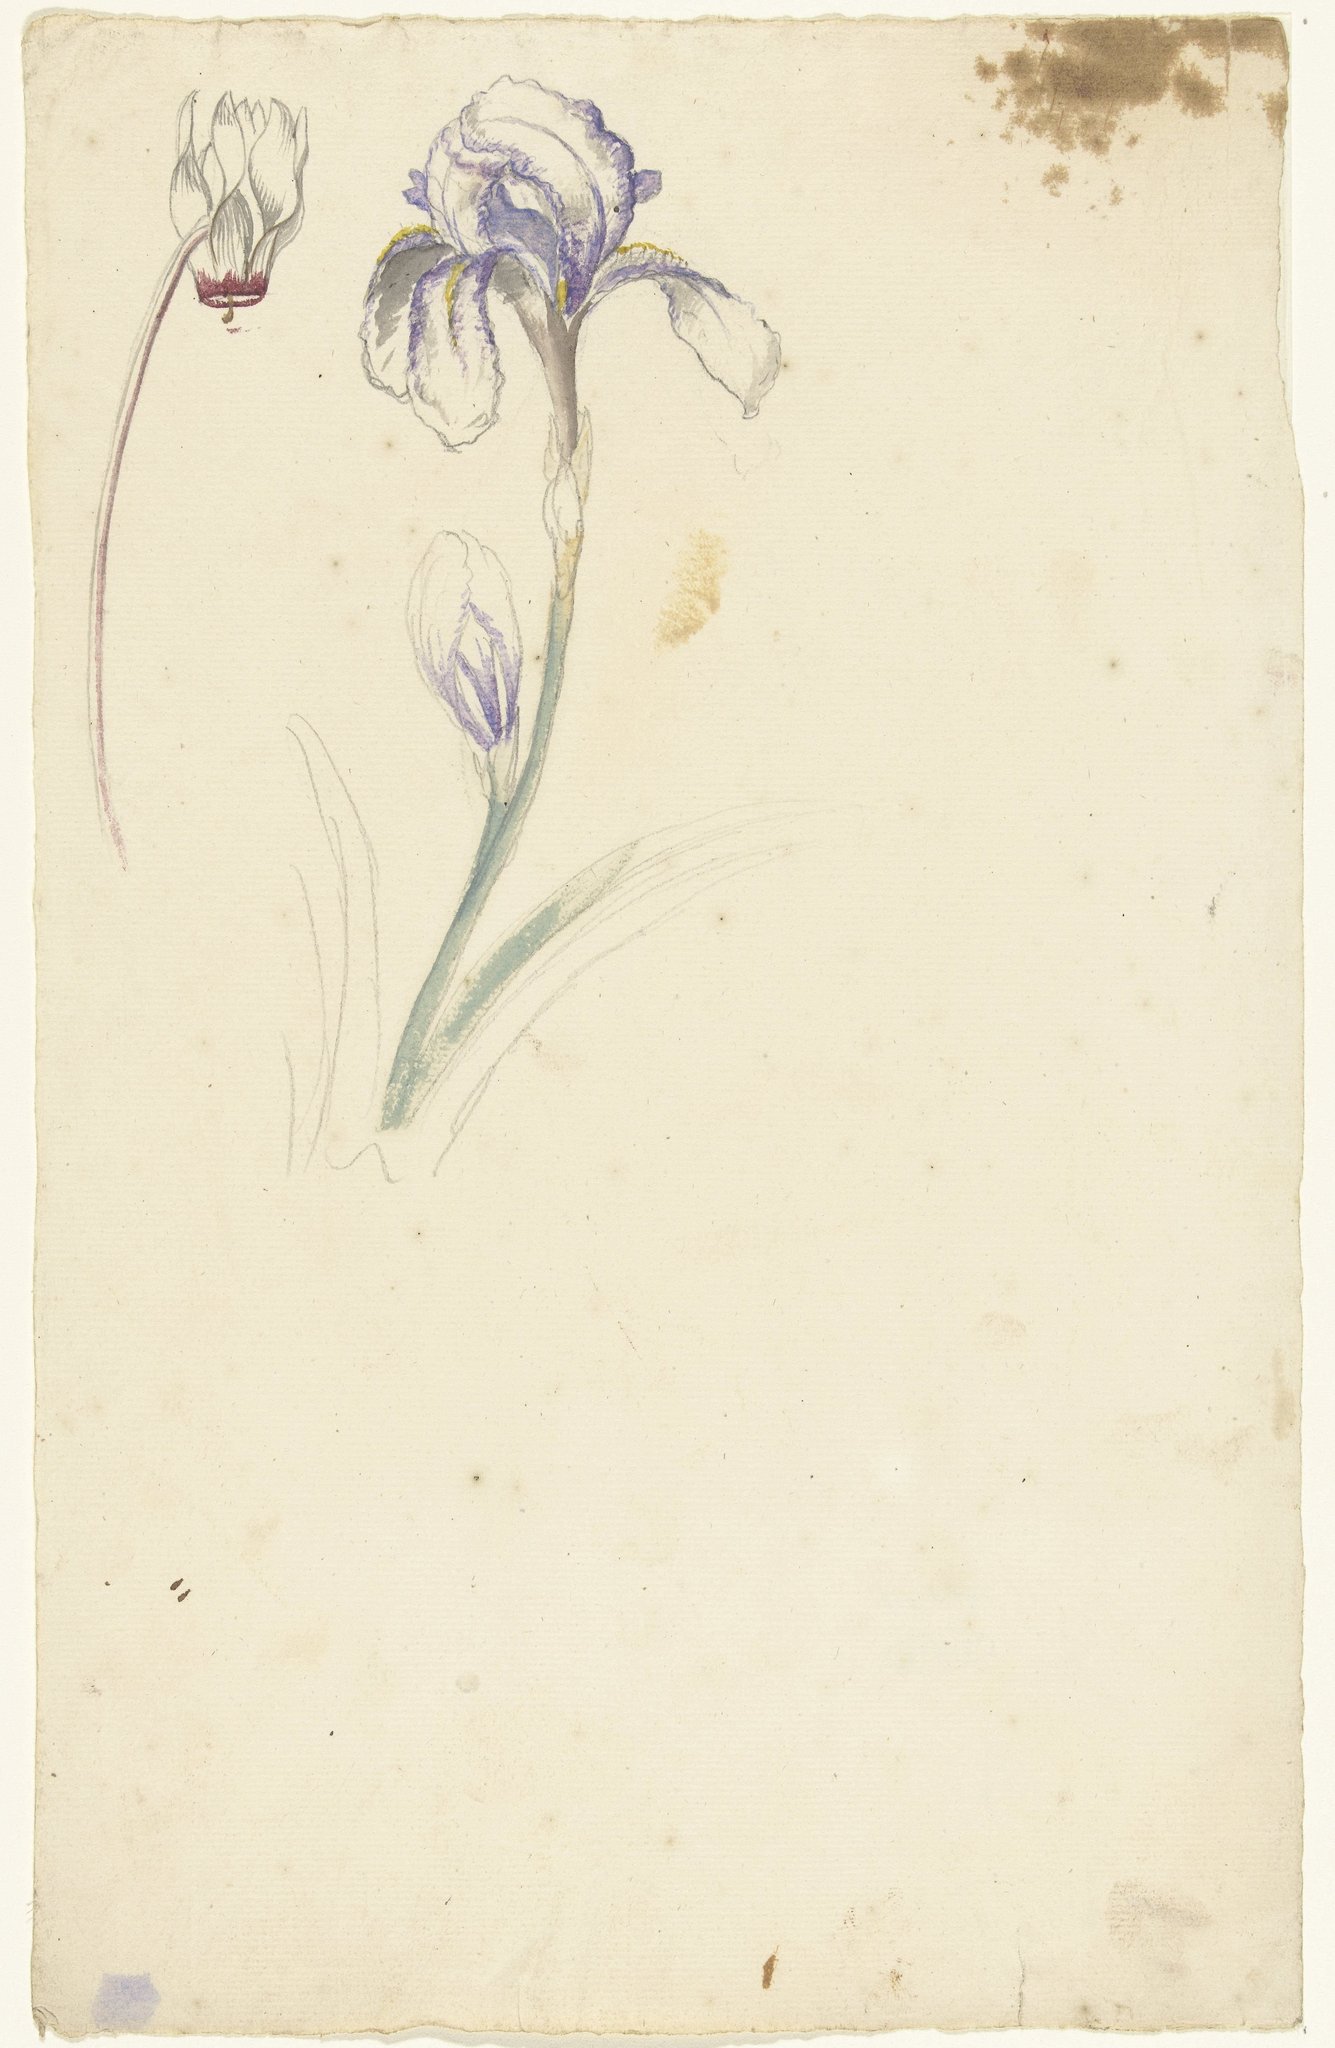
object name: drawing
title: Studie van iris en cyclaam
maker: elias van nijmegen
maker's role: draughtsman, painter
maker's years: 1667-1755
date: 1677-1755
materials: paper, pencil, watercolor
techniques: brush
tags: flowers: cyclamen, flowers: iris